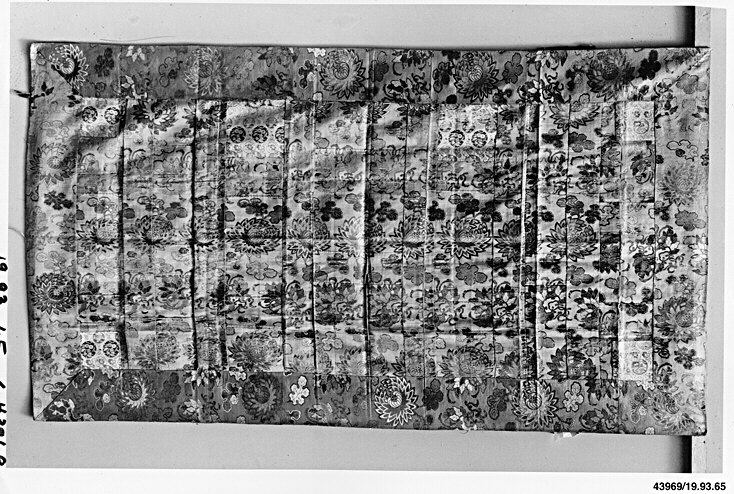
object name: robe, priest's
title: Priest's Robe (Shichijō)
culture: japanese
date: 1688-1704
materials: metal thread, silk